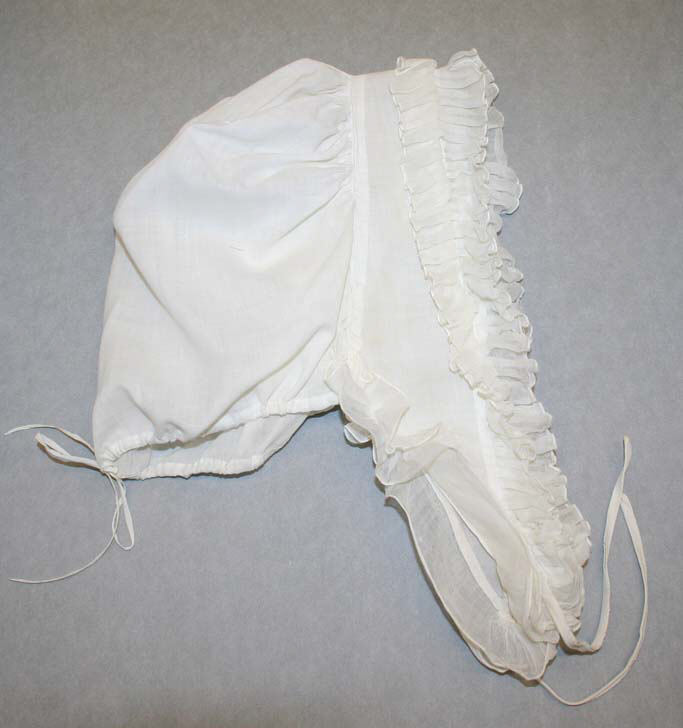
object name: bonnet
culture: american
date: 1812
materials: cotton